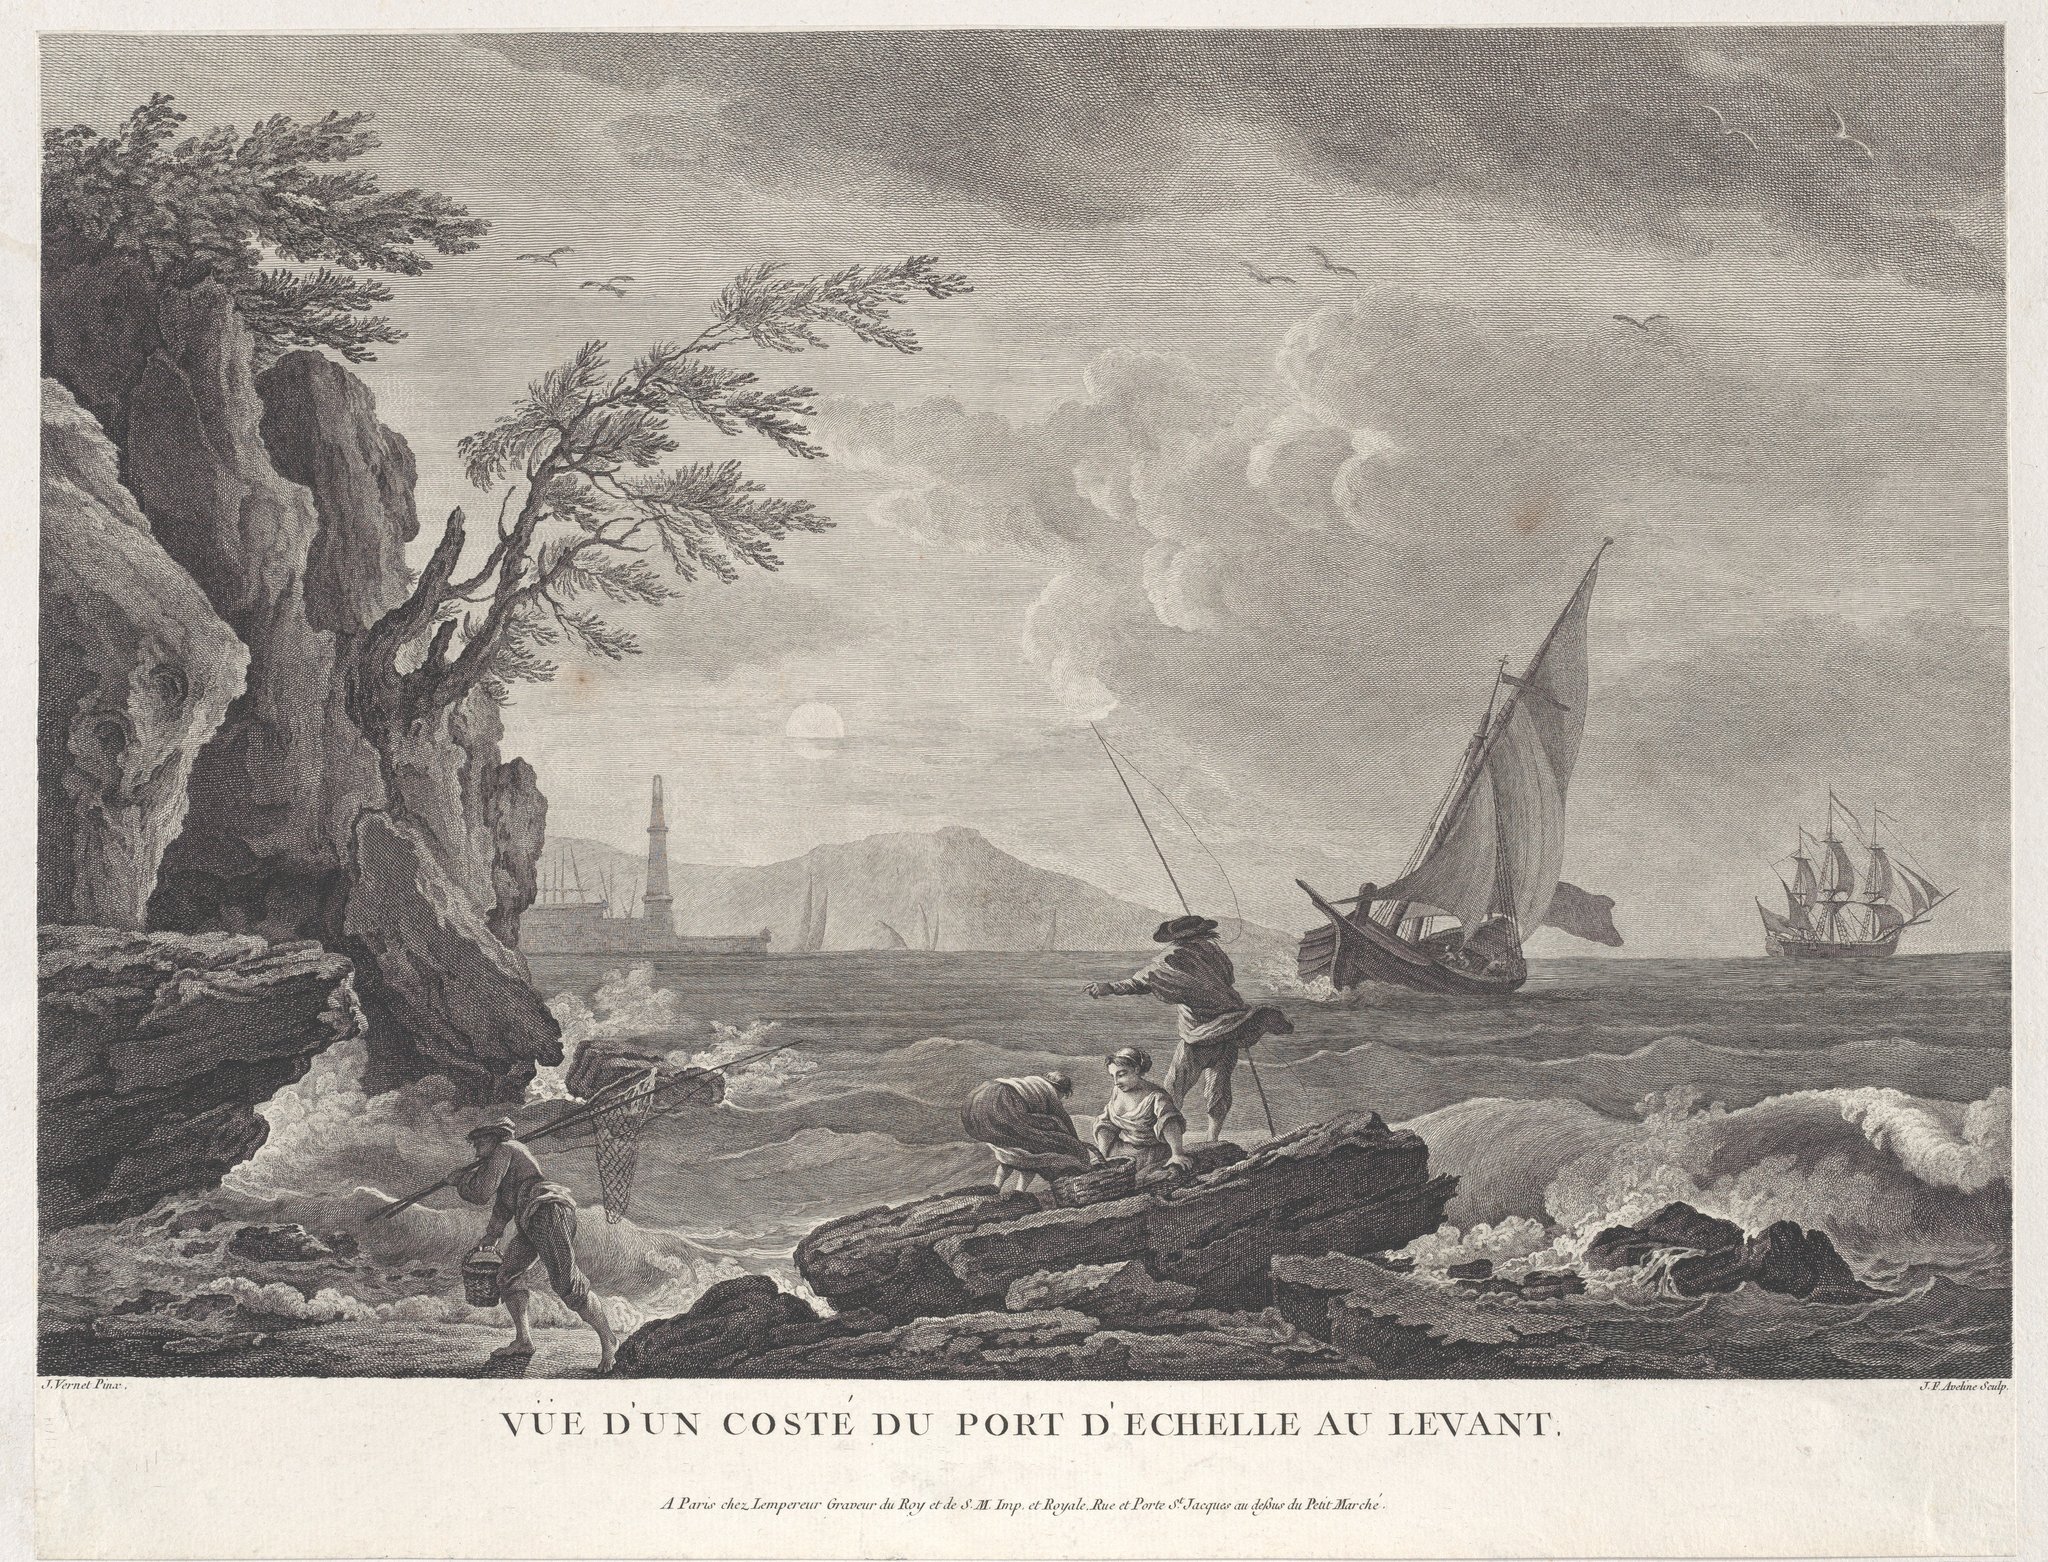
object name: print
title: Coastal View of a Port City in the Levant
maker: joseph vernet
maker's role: artist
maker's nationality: french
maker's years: 1714-1789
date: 1770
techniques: engraving